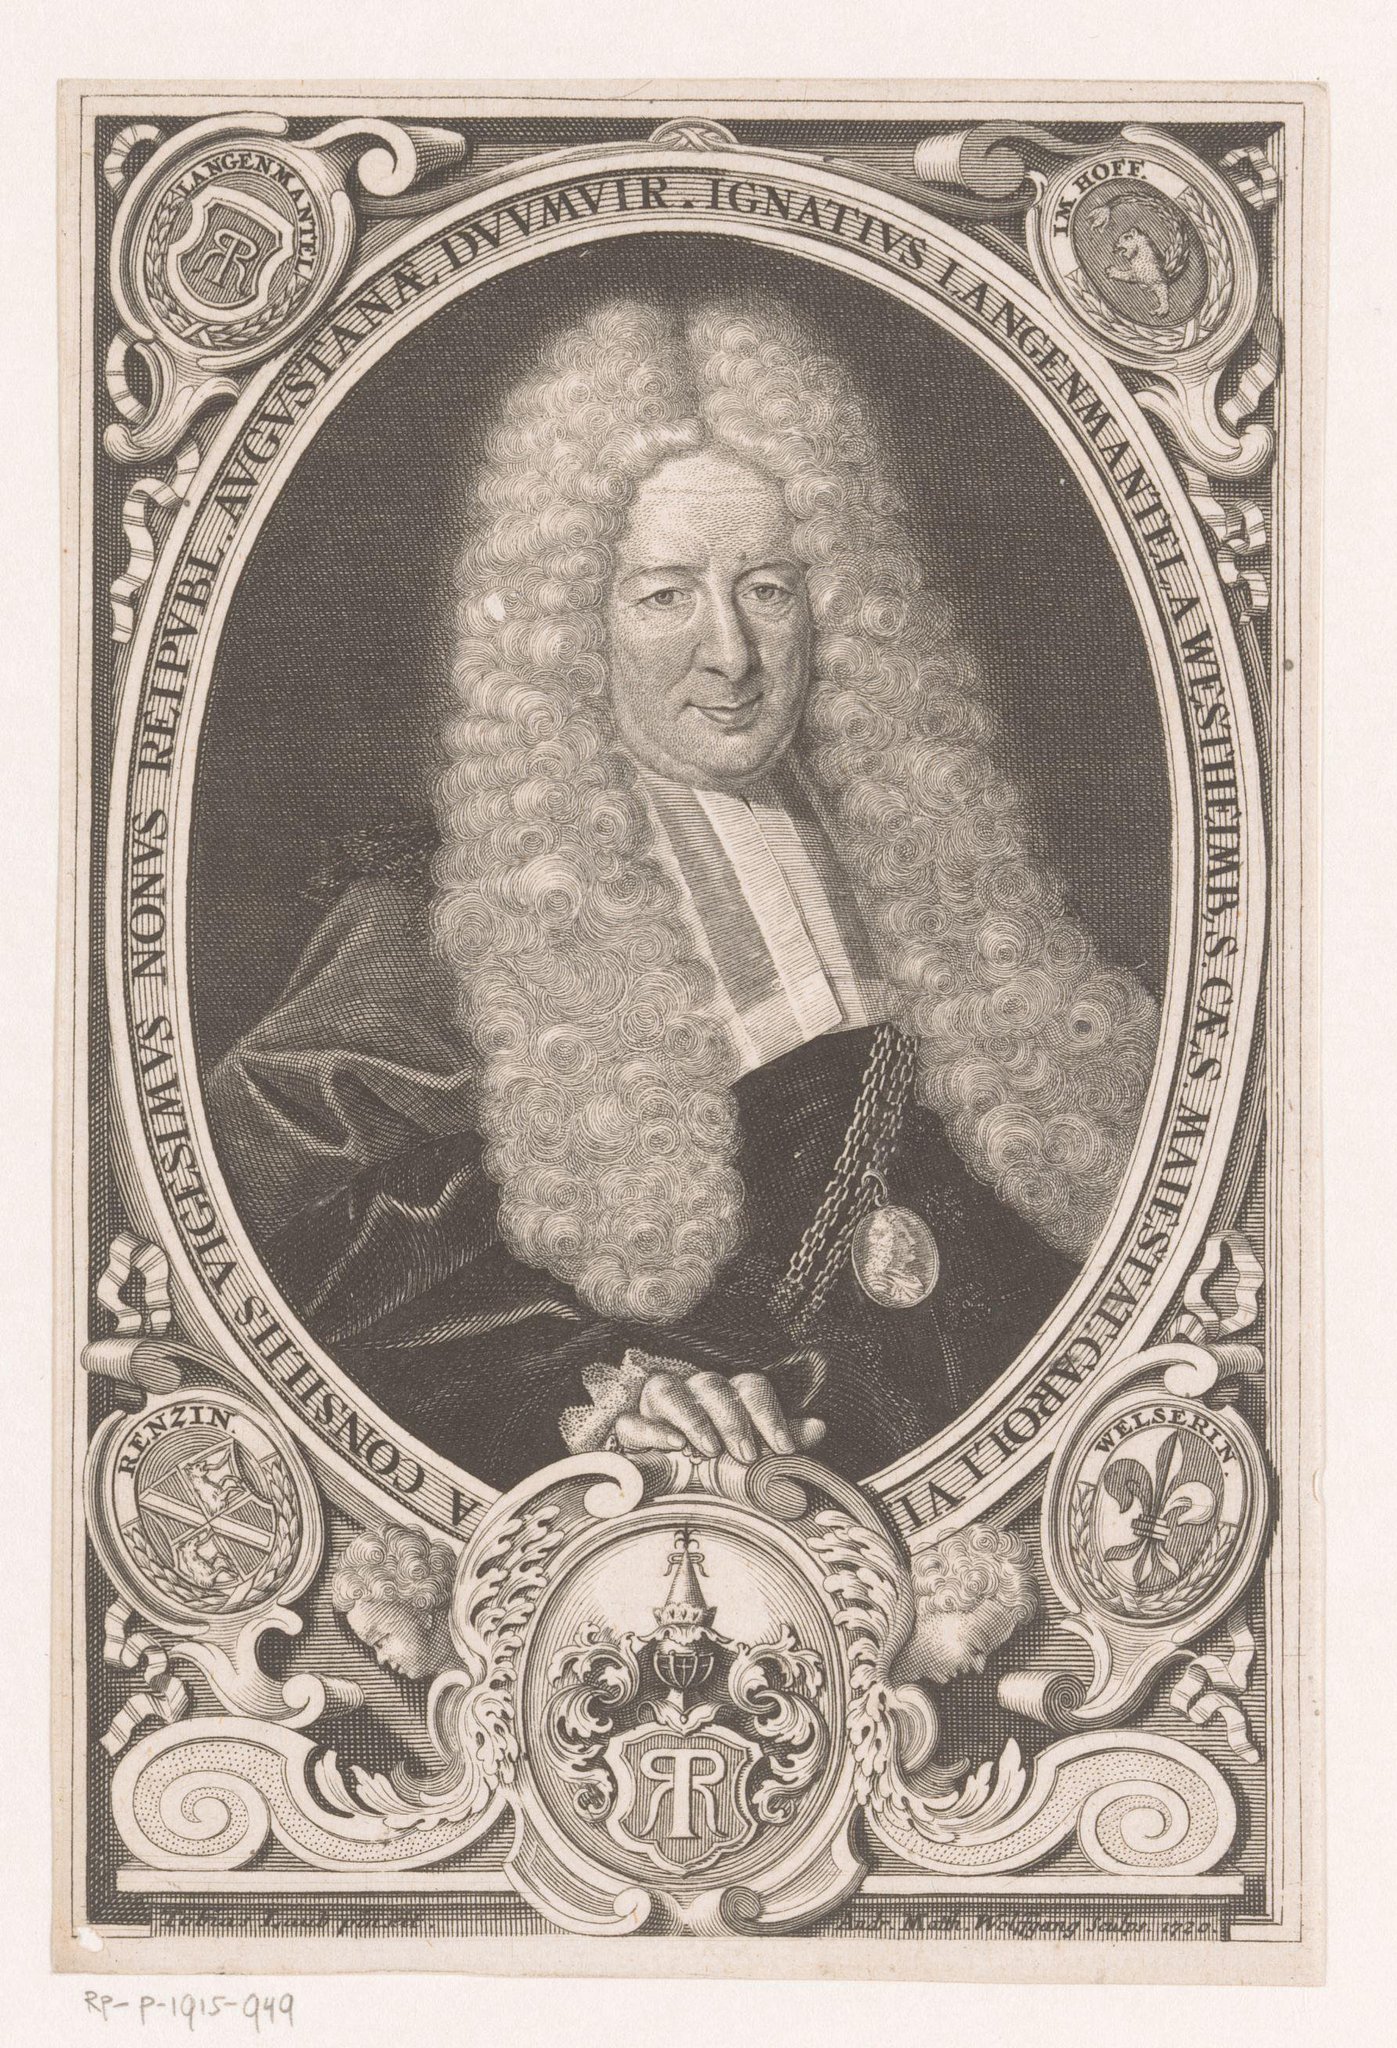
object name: print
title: Portret van Octavian Langenmantel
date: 1720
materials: paper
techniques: engraving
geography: germany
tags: politician, mayor, historical persons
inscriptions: collector's mark: Lugt 2228